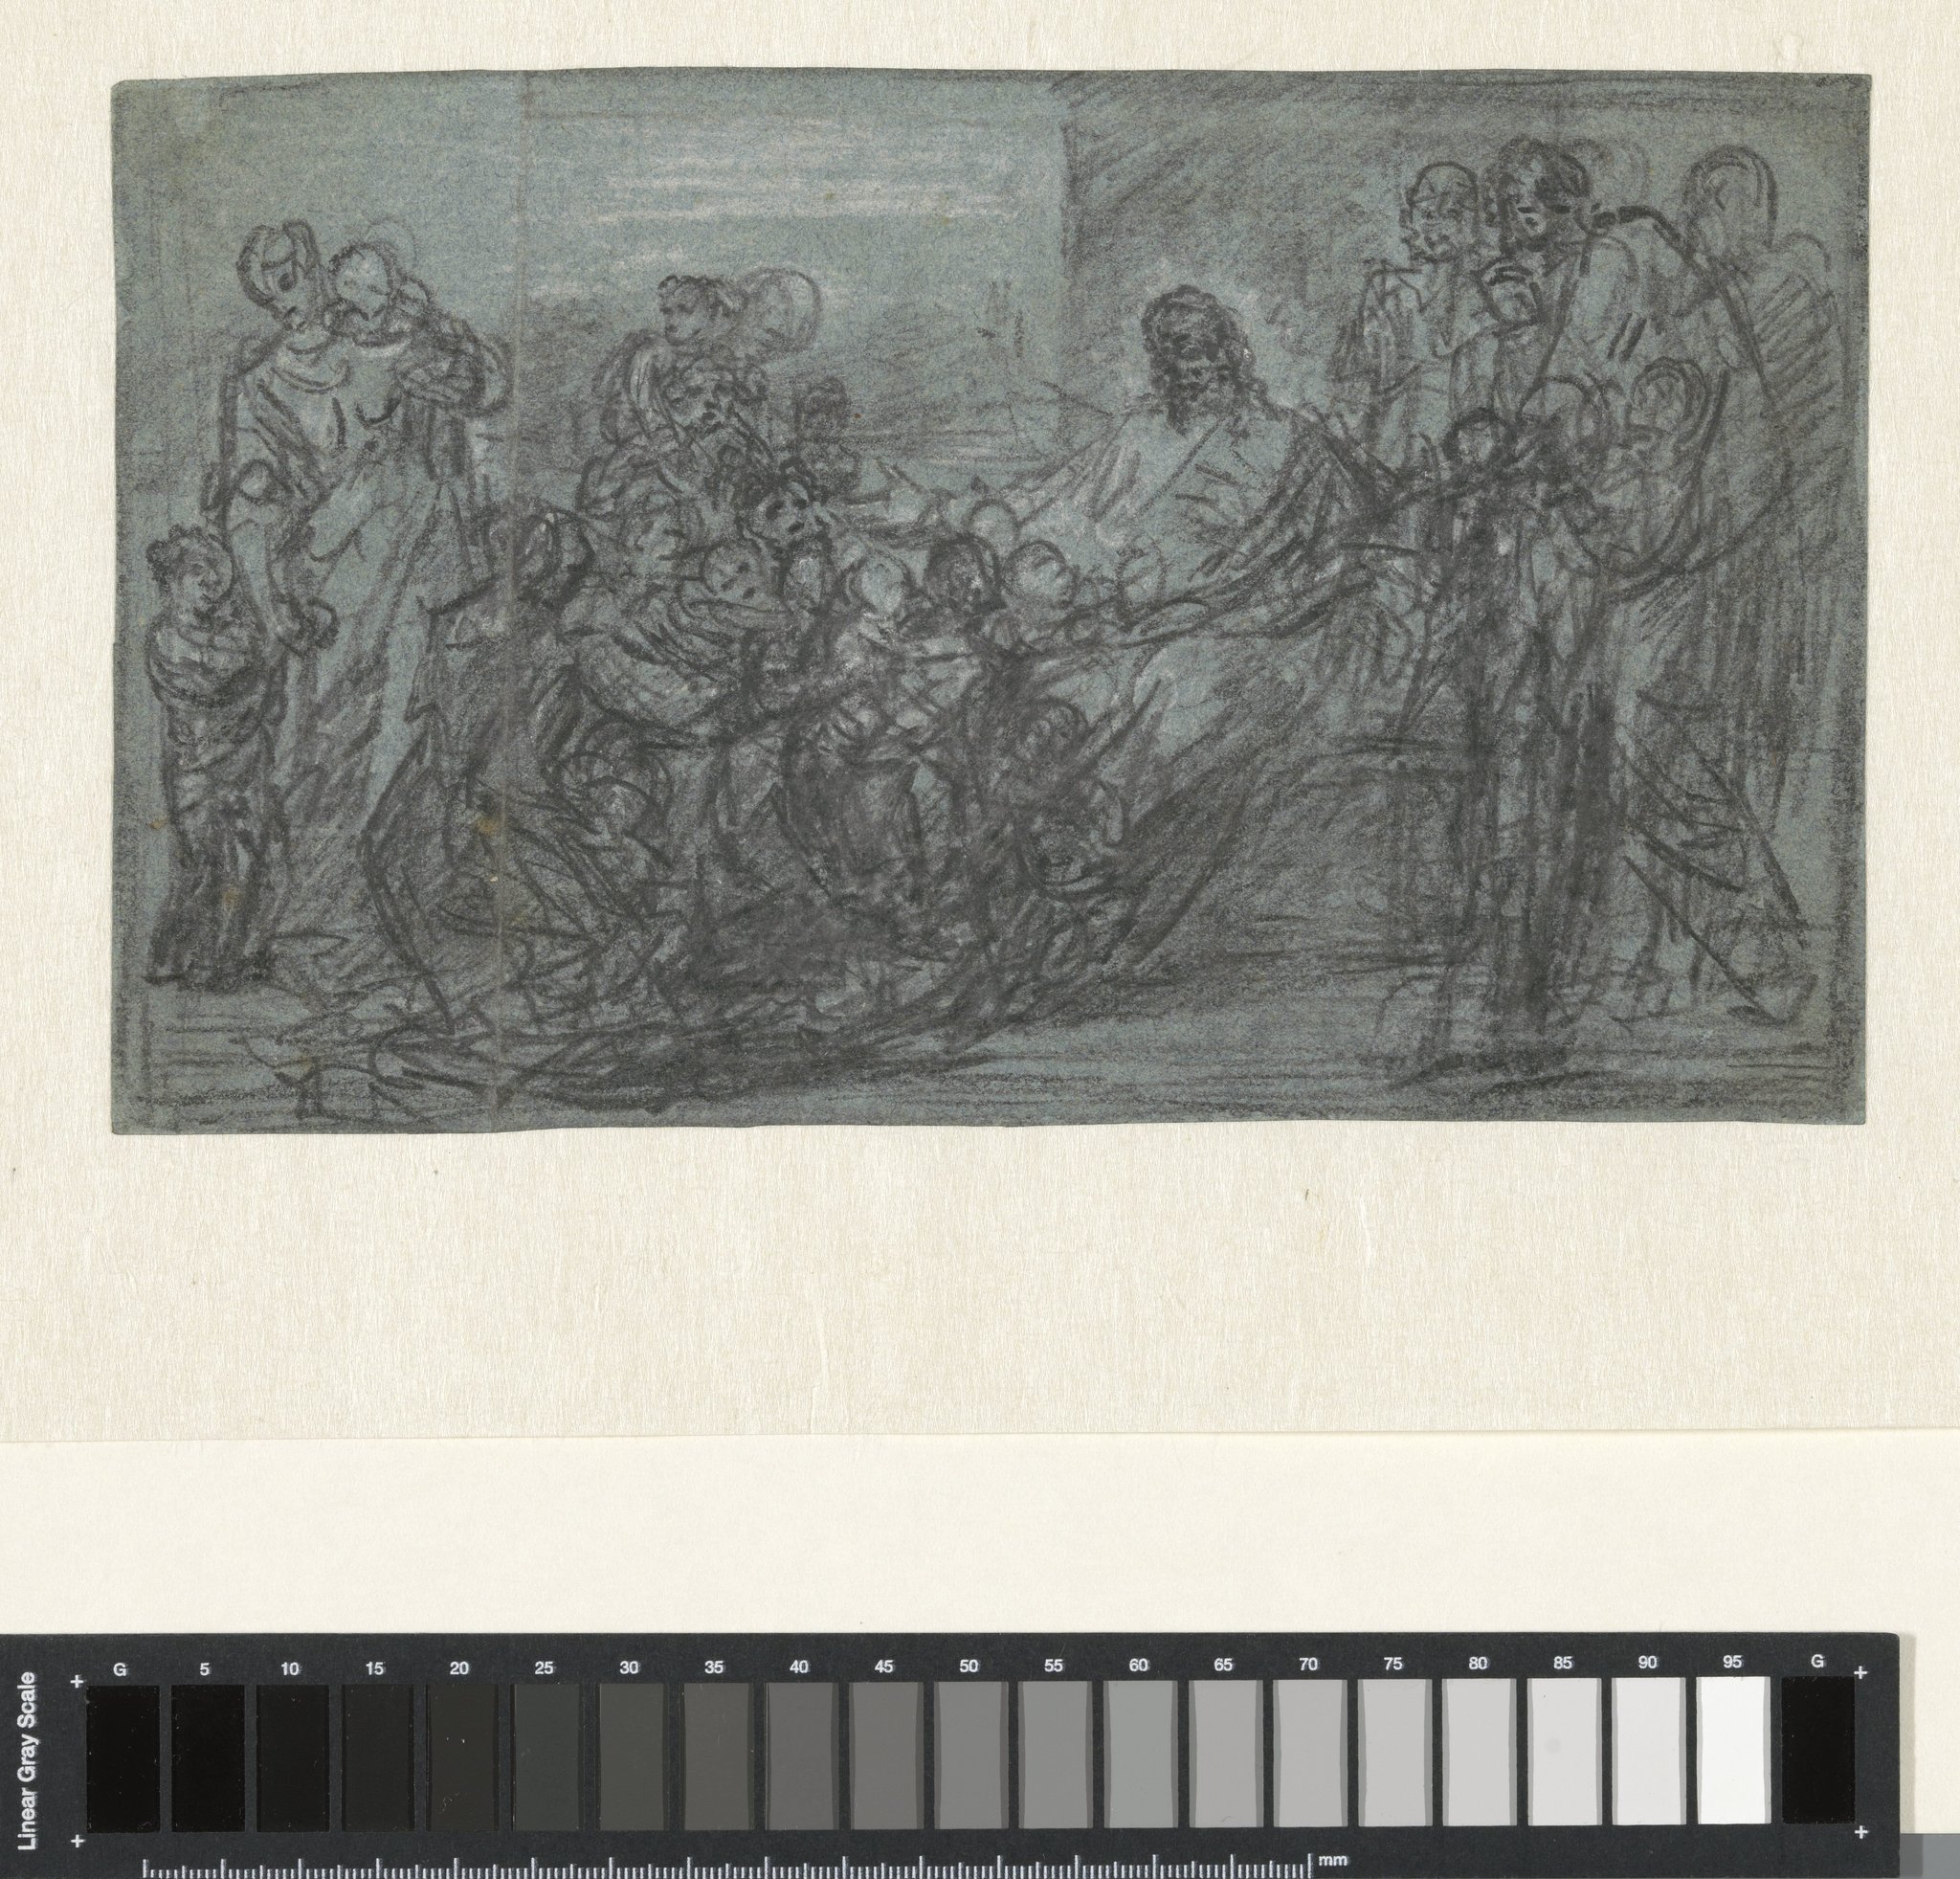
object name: drawing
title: Christus zegent de kinderen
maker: benjamin west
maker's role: draughtsman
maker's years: 1738-1820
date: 1776-1781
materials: chalk, paper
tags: christ blessing children brought by their mothers, usually with some disciples disapprovingly looking on (matthew 19:13-15; mark 10:13-16; luke 18:15-17)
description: Voorstudie voor het schilderij in de Royal Academy of Arts te Londen.